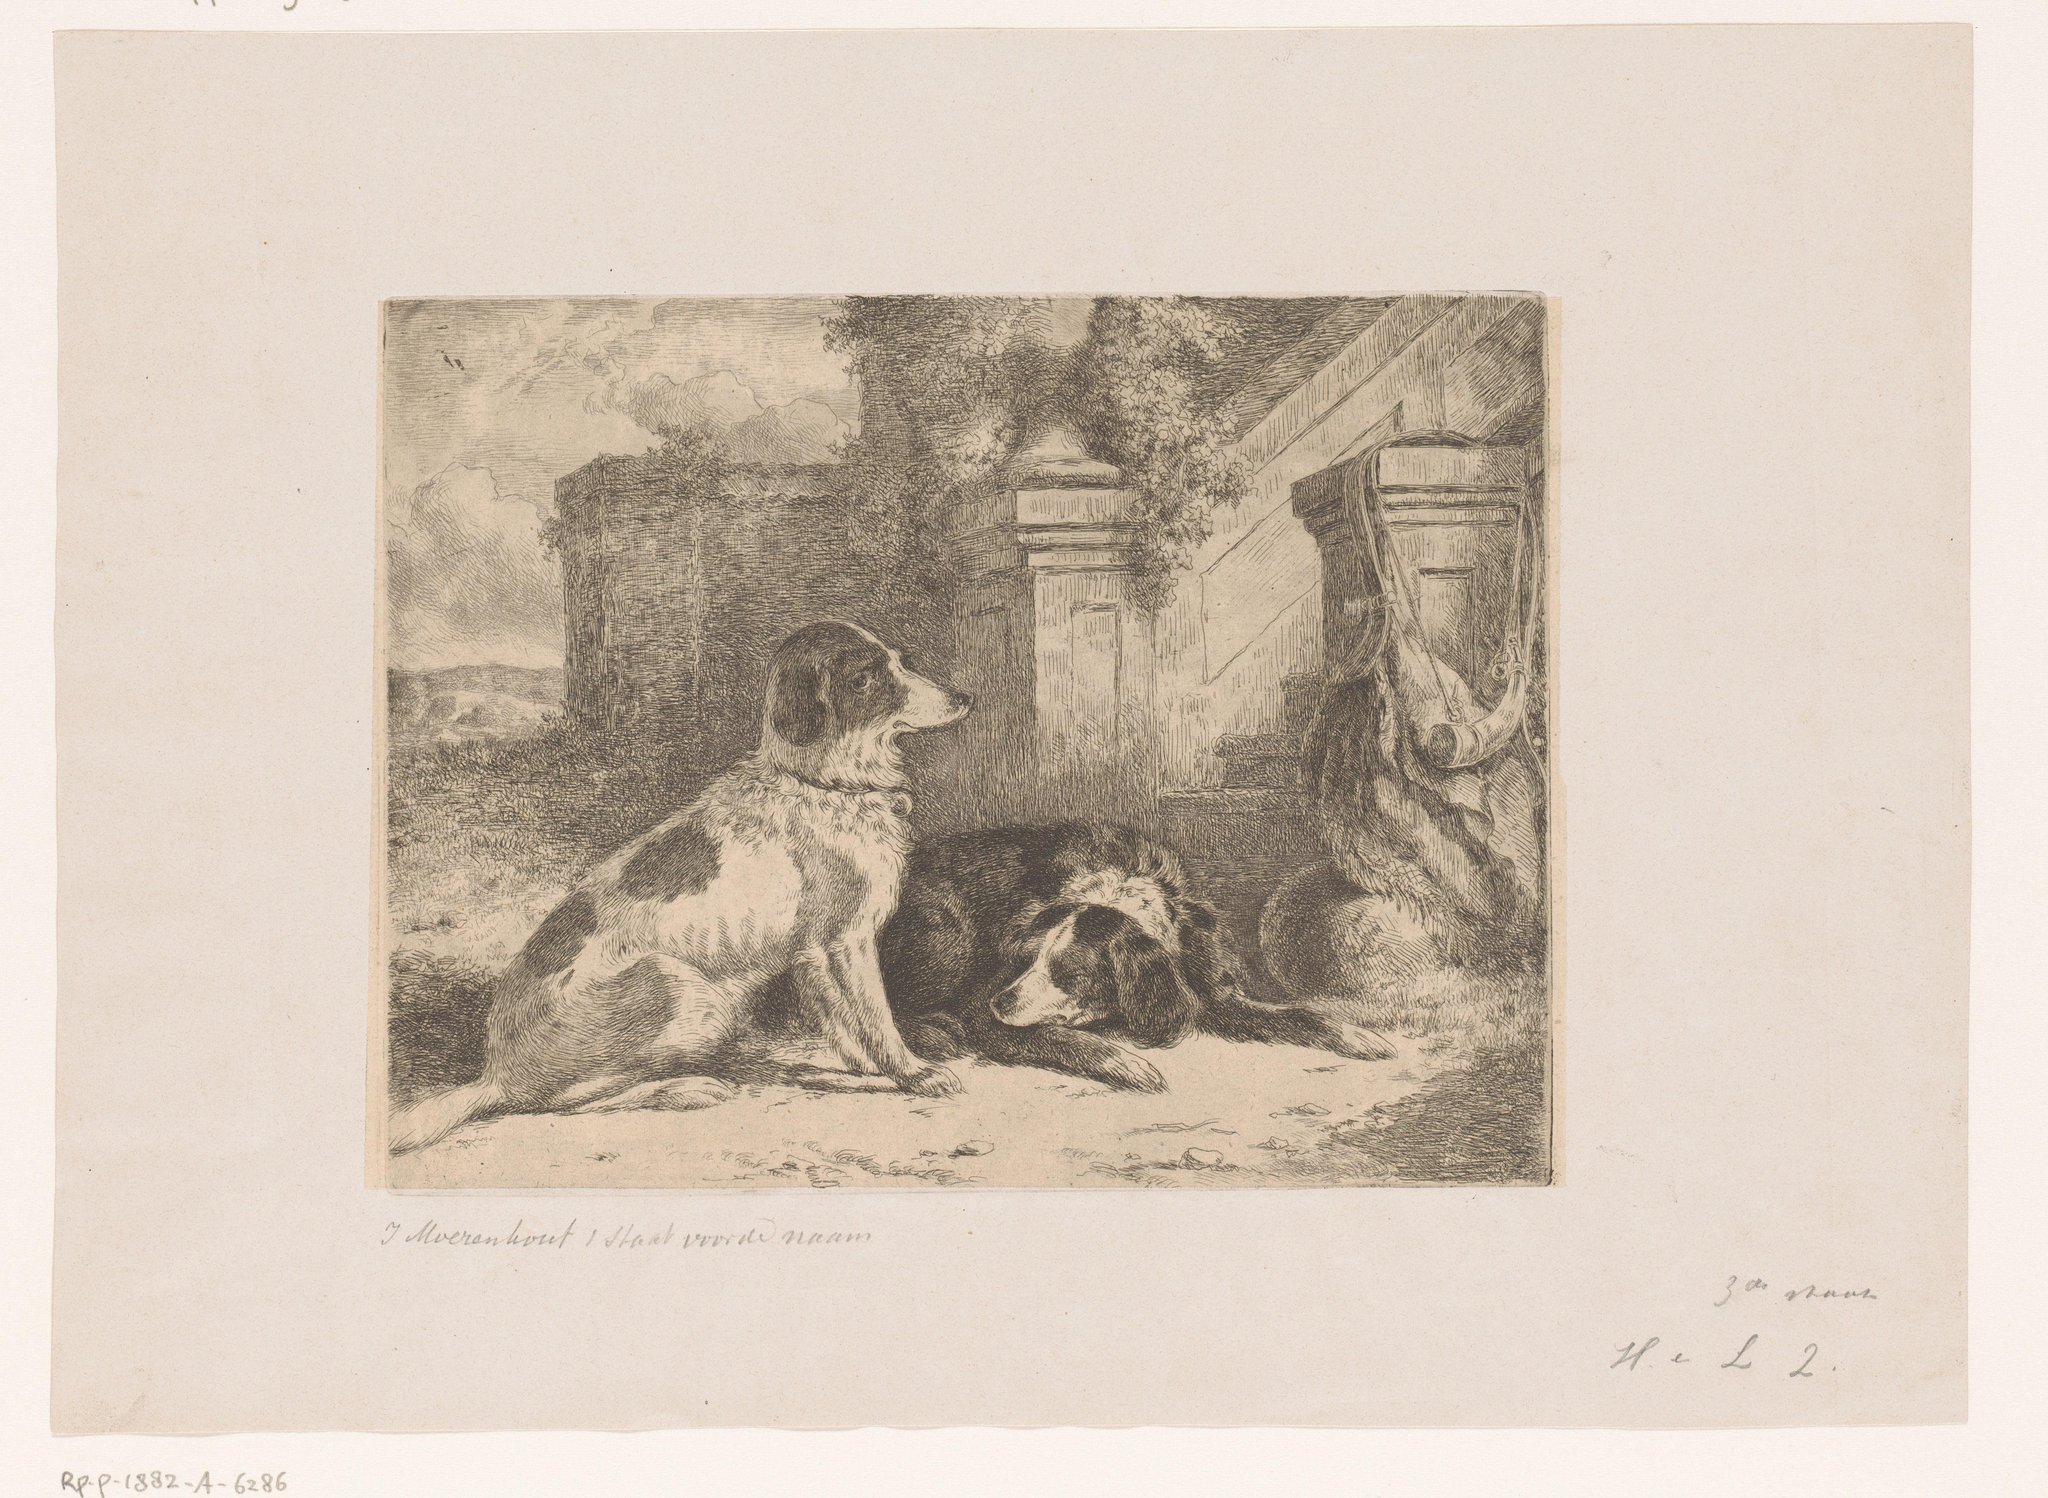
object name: print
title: Twee patrijshonden bij een trap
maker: joseph moerenhout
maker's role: draughtsman, painter, print maker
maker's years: 1801-1874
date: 1811-1874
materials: paper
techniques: etching, intaglio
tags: hunting dogs, hunting horn, front steps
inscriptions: collector's mark: Lugt 2228